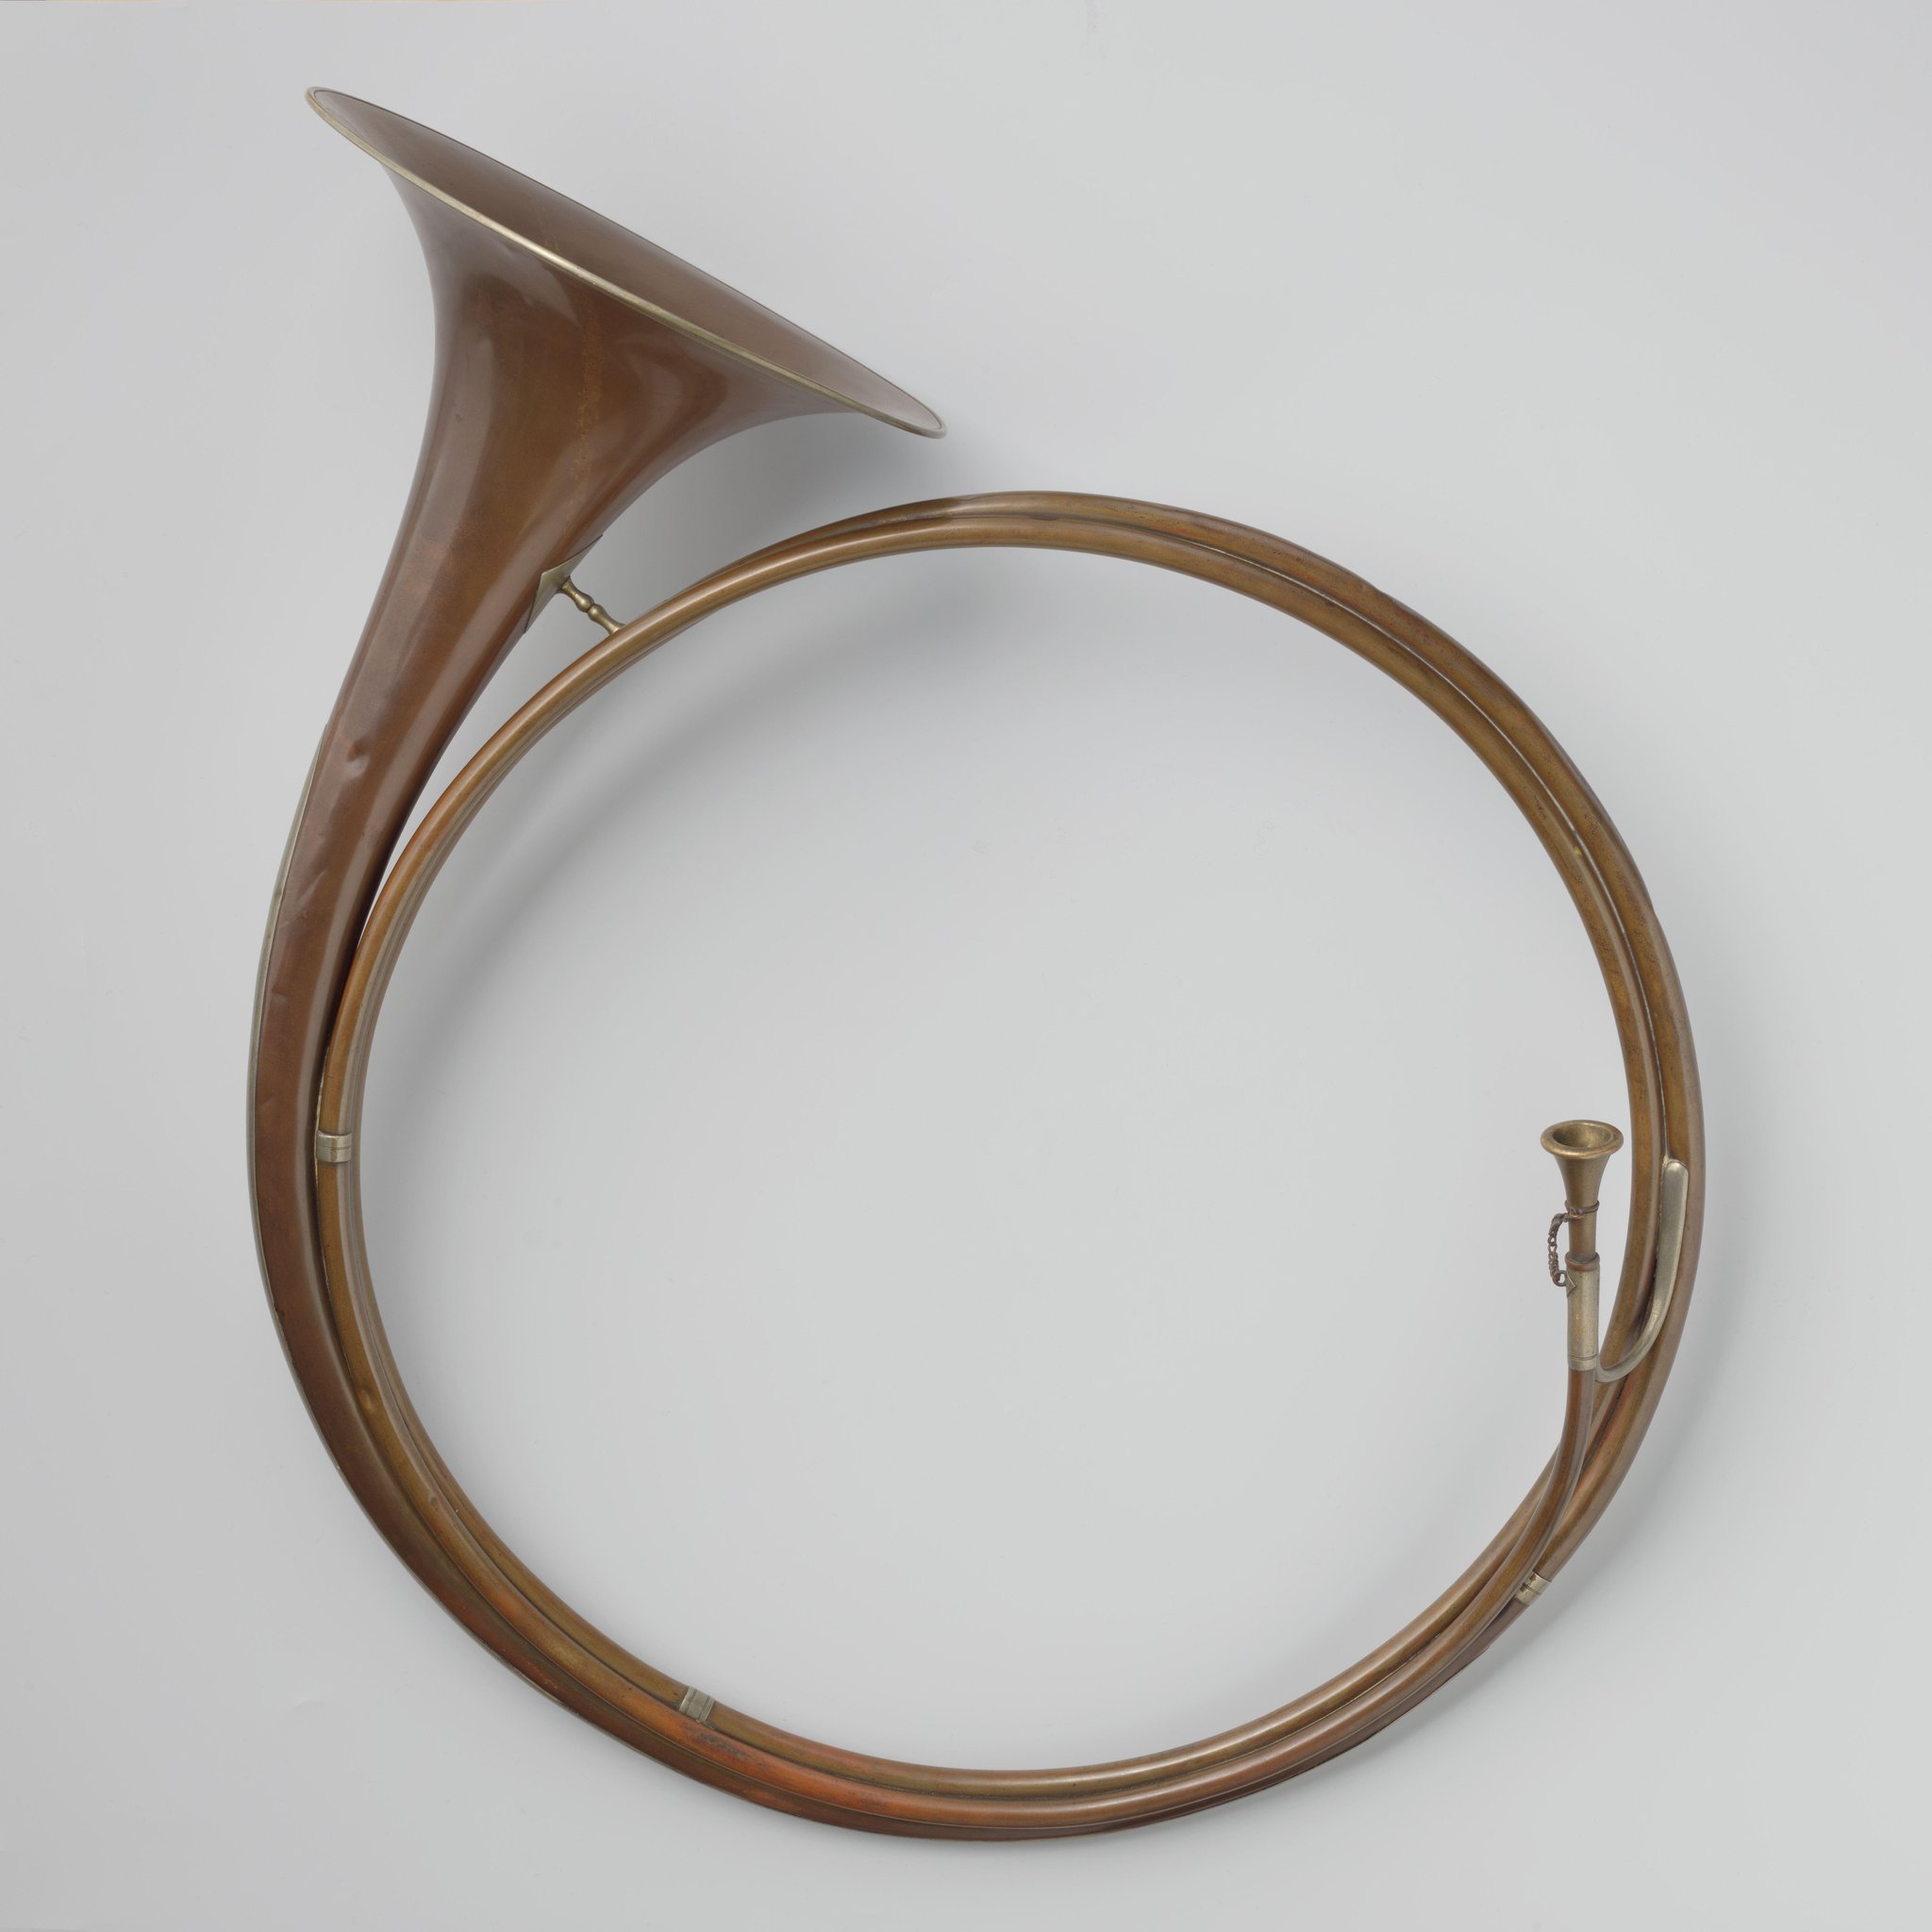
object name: hunting horn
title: Natural horn (hunting horn)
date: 1876-1896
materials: alloy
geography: königgrätz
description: Jachthoorn (parforce-hoorn) in D. Op de beker gegraveerd 'V. F. Cervény et Fils à Königgrätz en Boheme'. Rondom de beker is een krans van nieuwzilver gelegd. Drie windingen. de roerpijp is naar binnen gebogen. Het mondstuk is met en kettinkje aan de hoofdbuis devestigd.